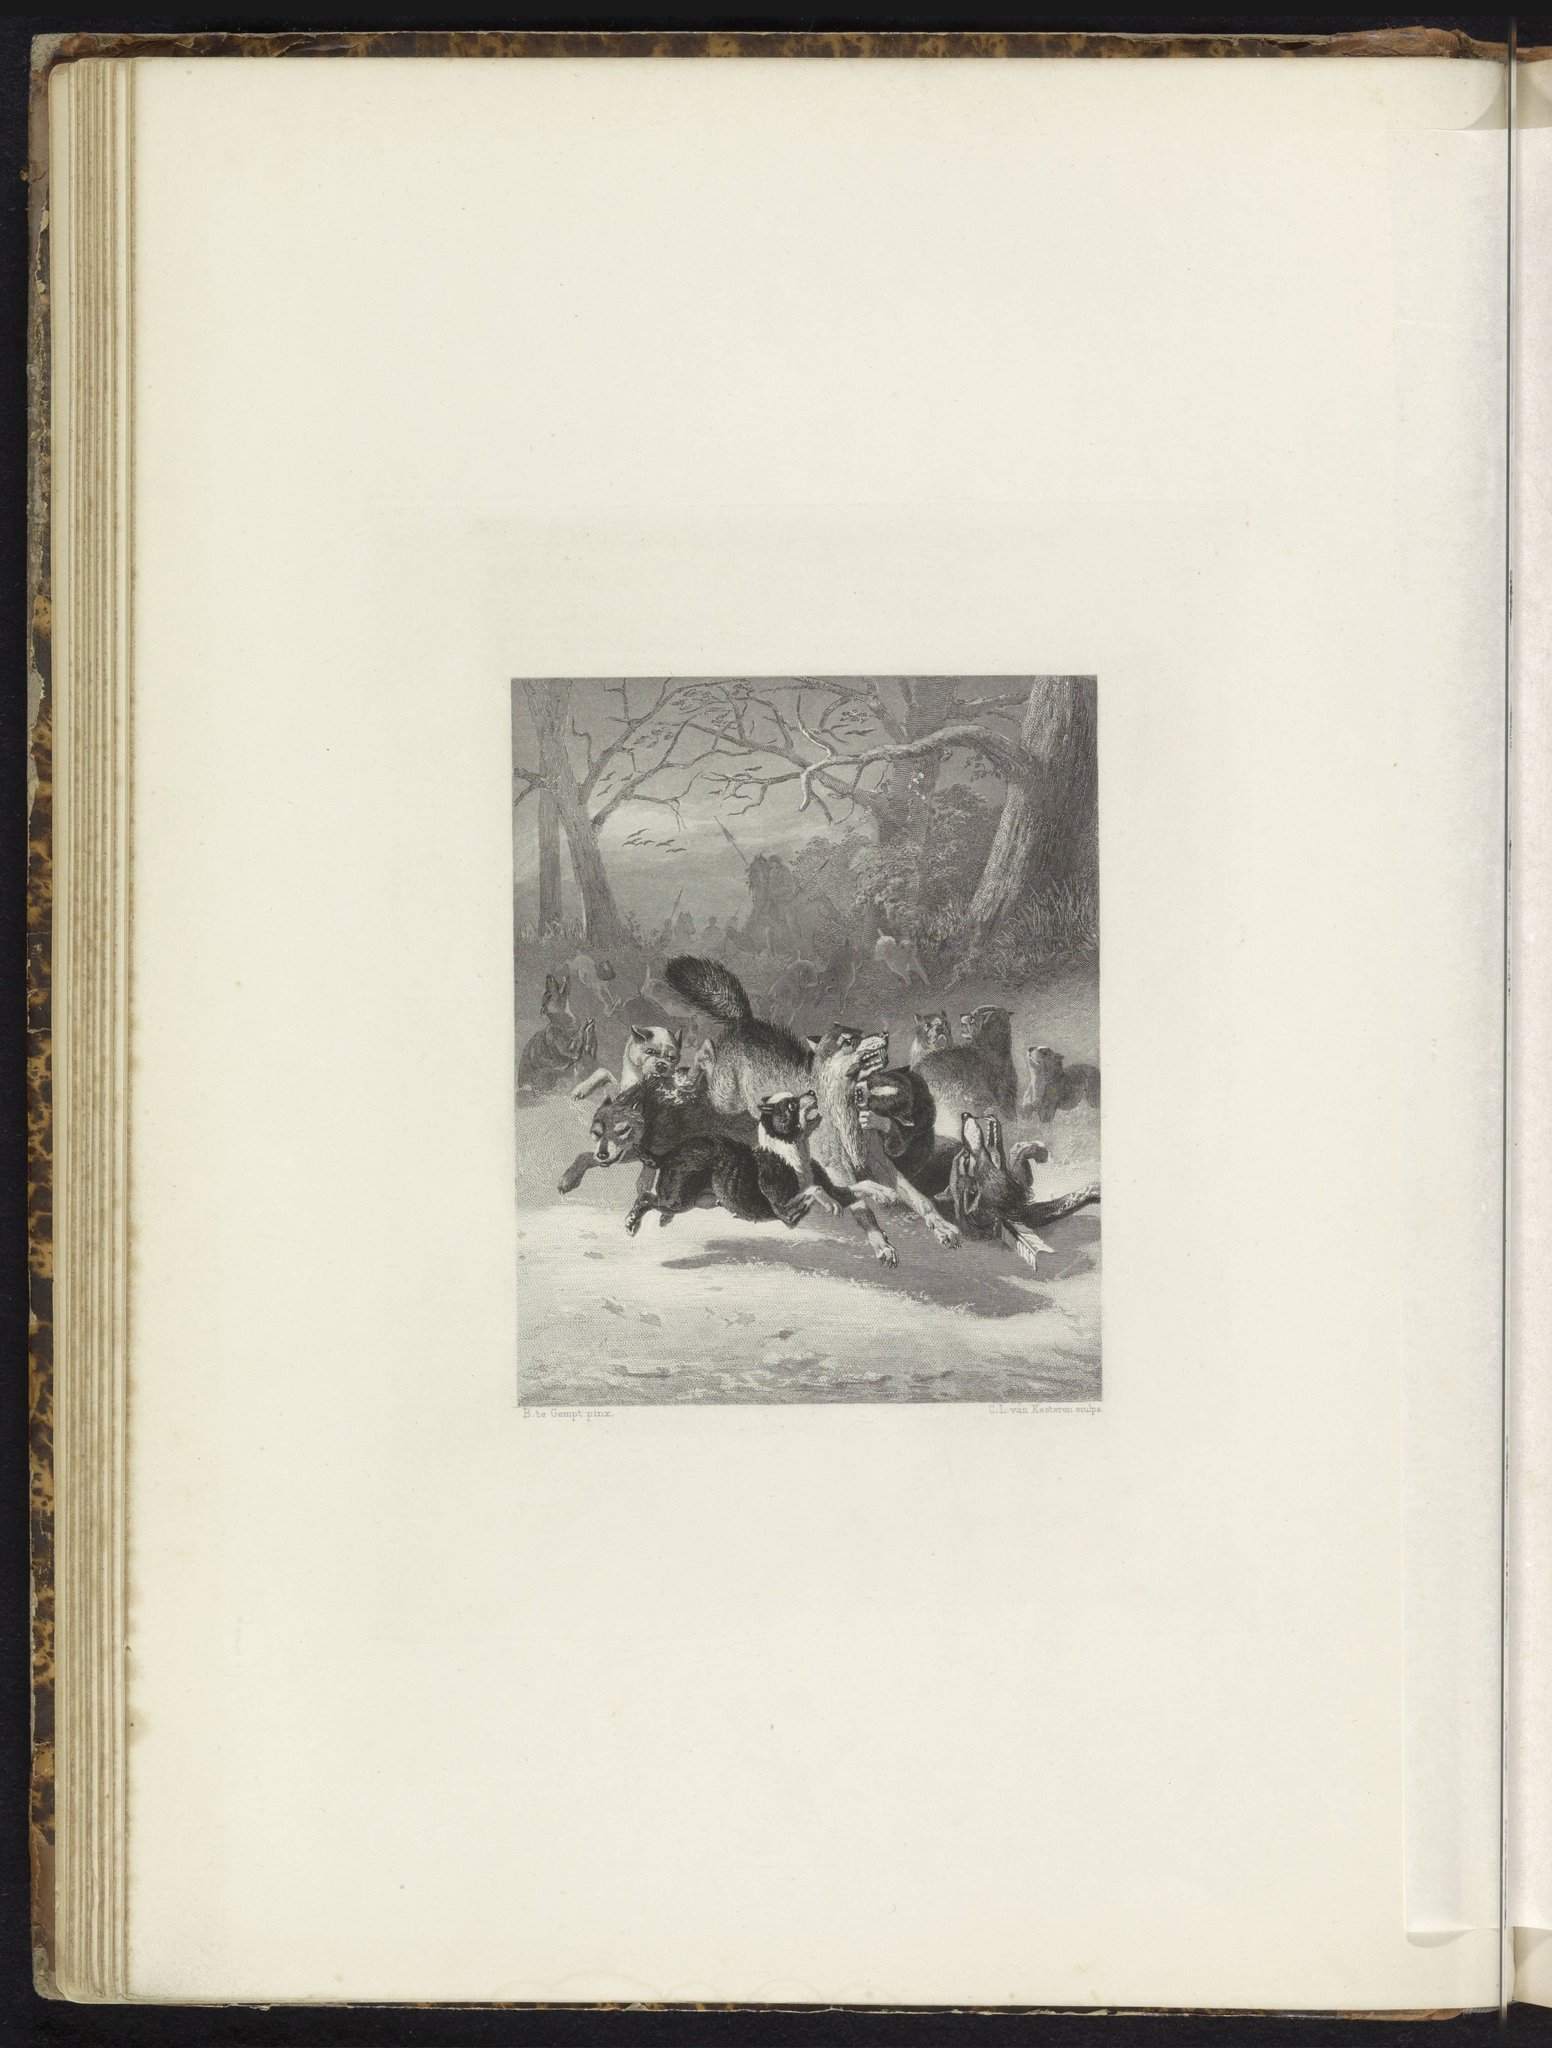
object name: print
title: Wolvenjacht, ca. 6e eeuw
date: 1865-1870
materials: paper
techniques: engraving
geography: netherlands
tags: hunting, chase, beasts of prey, predatory animals: wolf, netherlands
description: Een drijfjacht op wolven, in het Nederland van ca. 6e eeuw. Jachthonden vallen wolven aan. Onderdeel van de groep staalgravures naar de schilderijen van de Historische Galerij der Maatschappij Arti et Amicitiae.